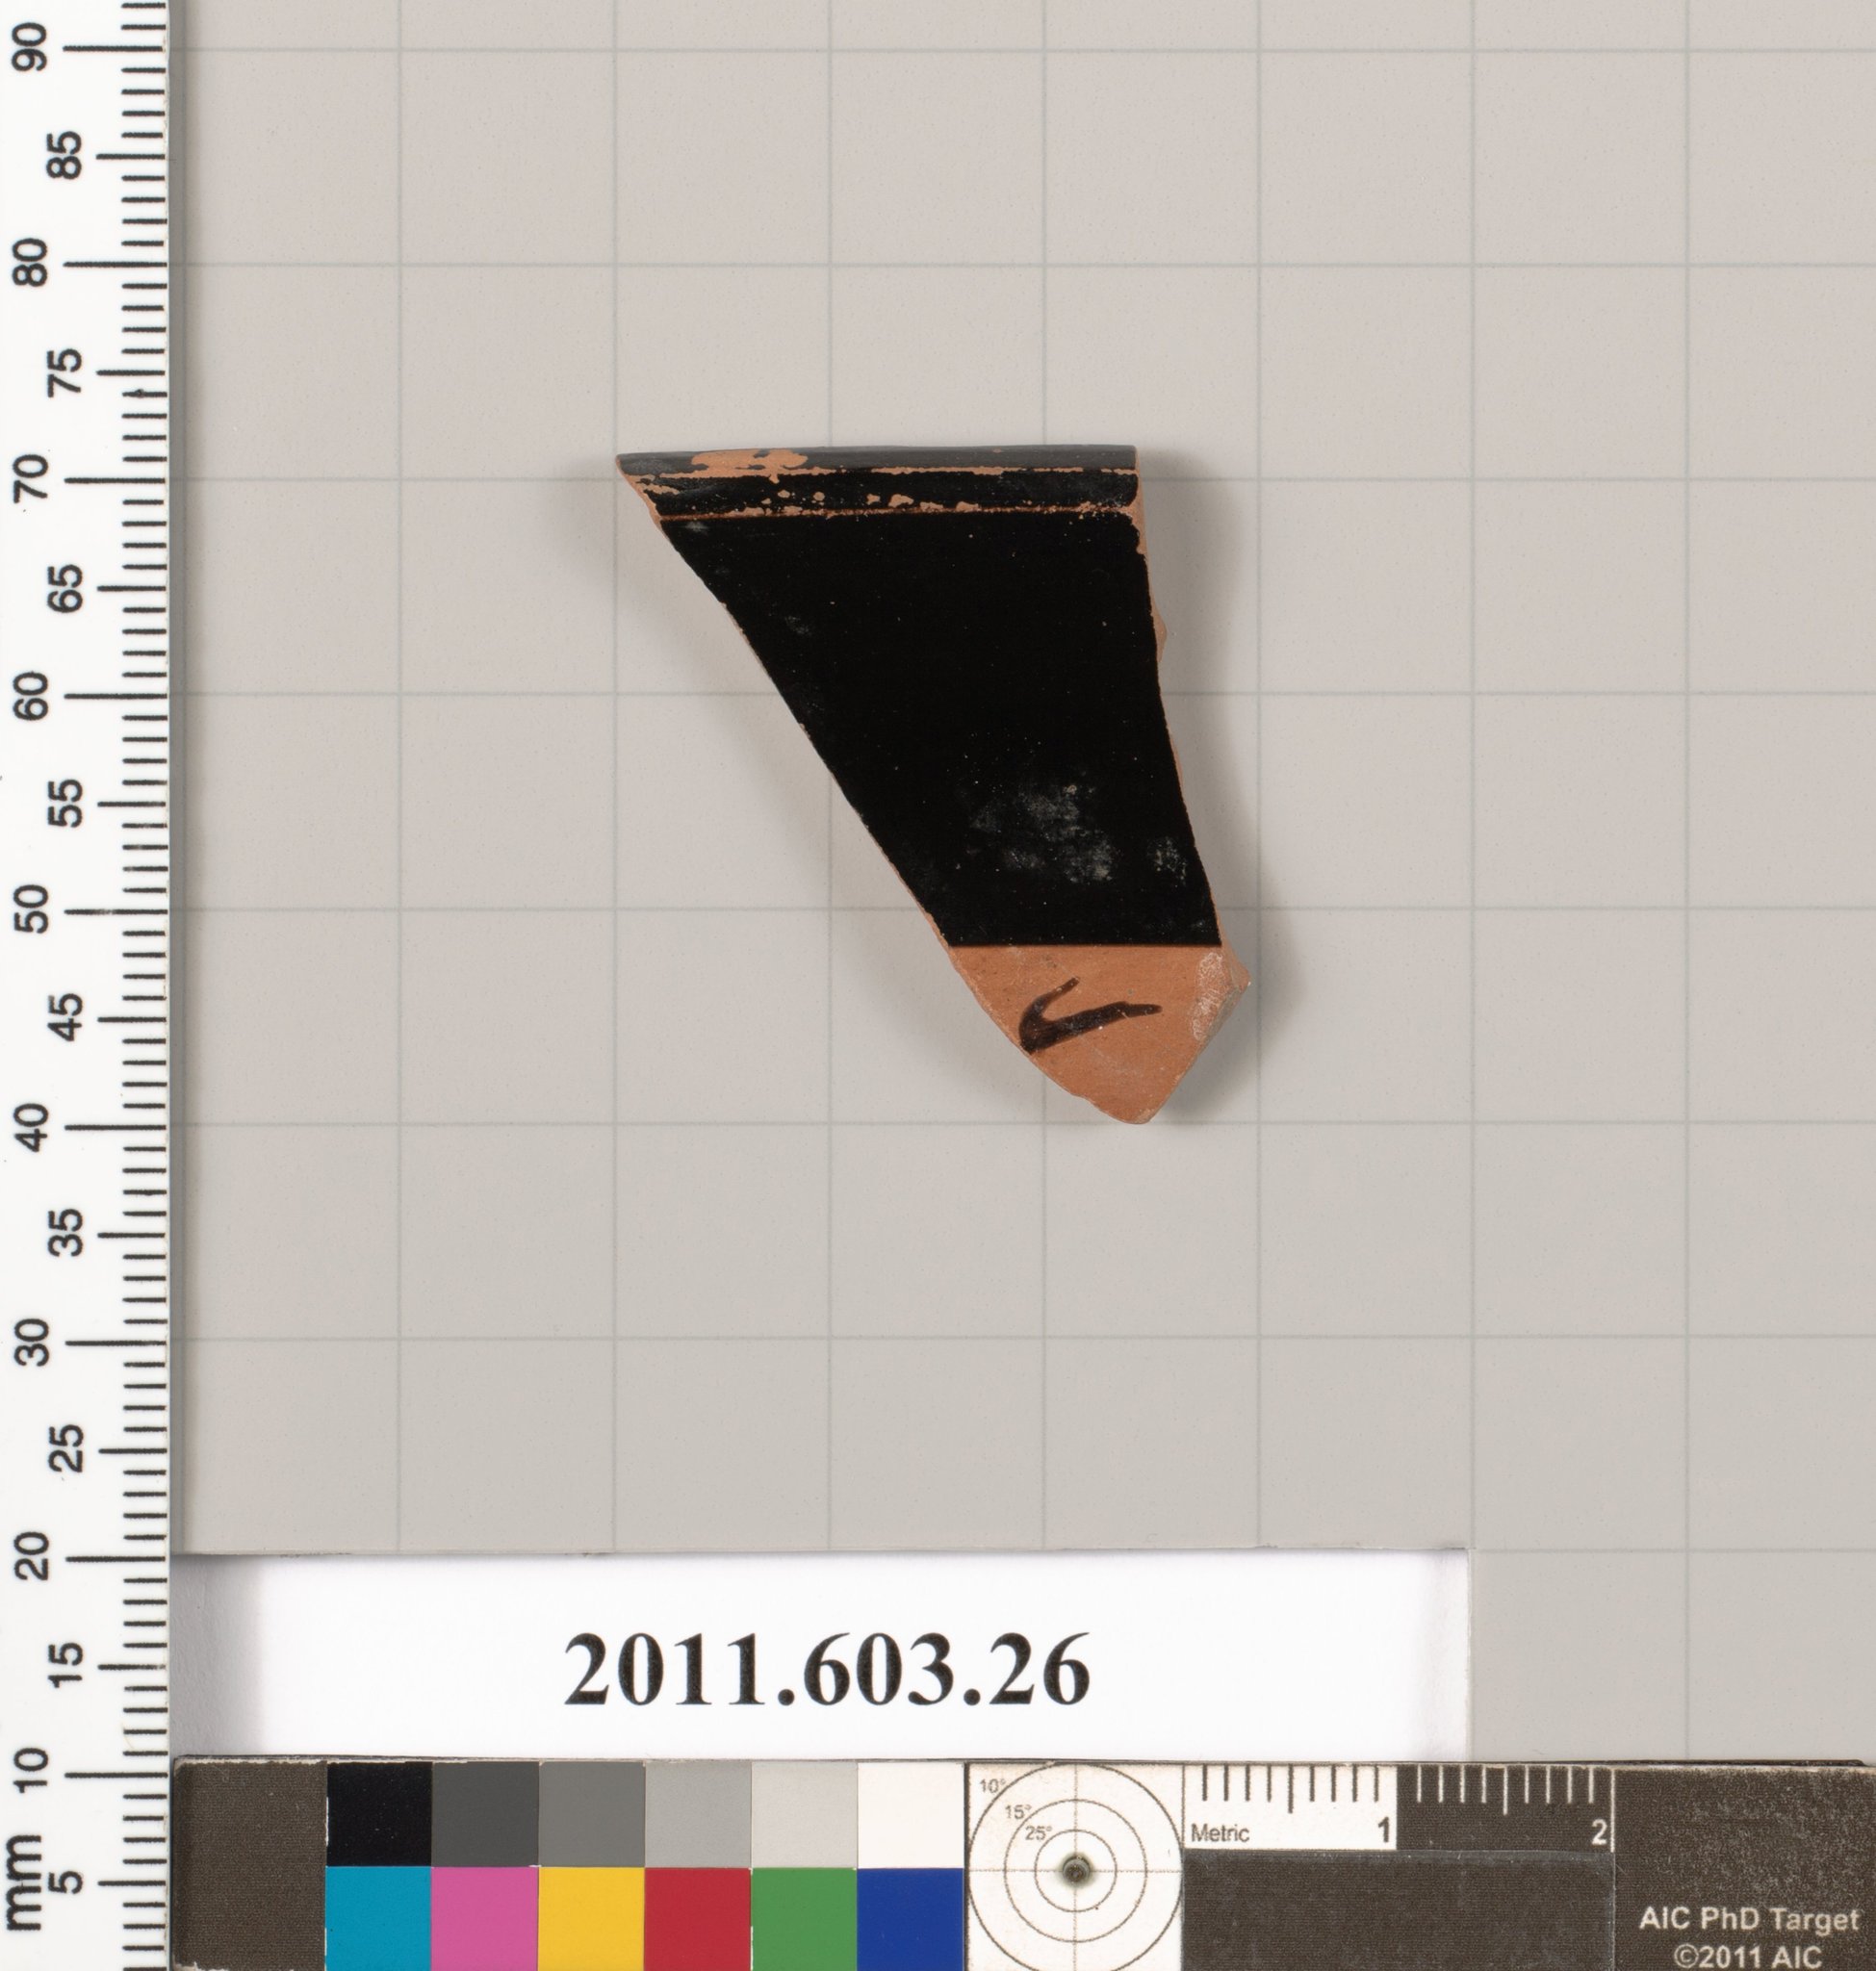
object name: kylix fragment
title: Terracotta rim fragment of a kylix:band-cup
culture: greek, attic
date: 567-535 BCE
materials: terracotta